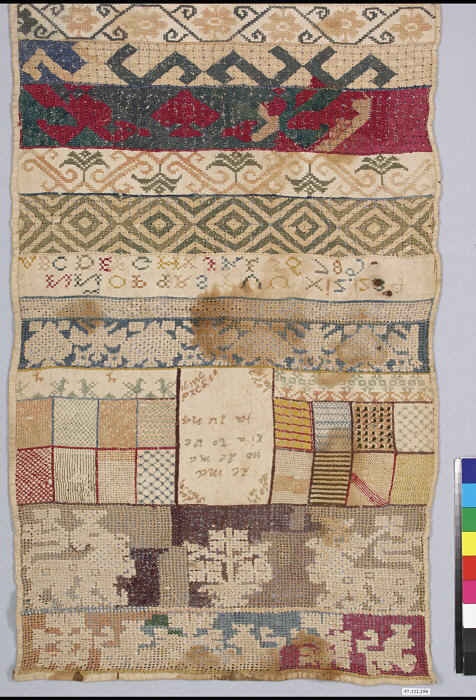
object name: sampler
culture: mexican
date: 1801-1900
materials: linen, silk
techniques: embroidery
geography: mexico